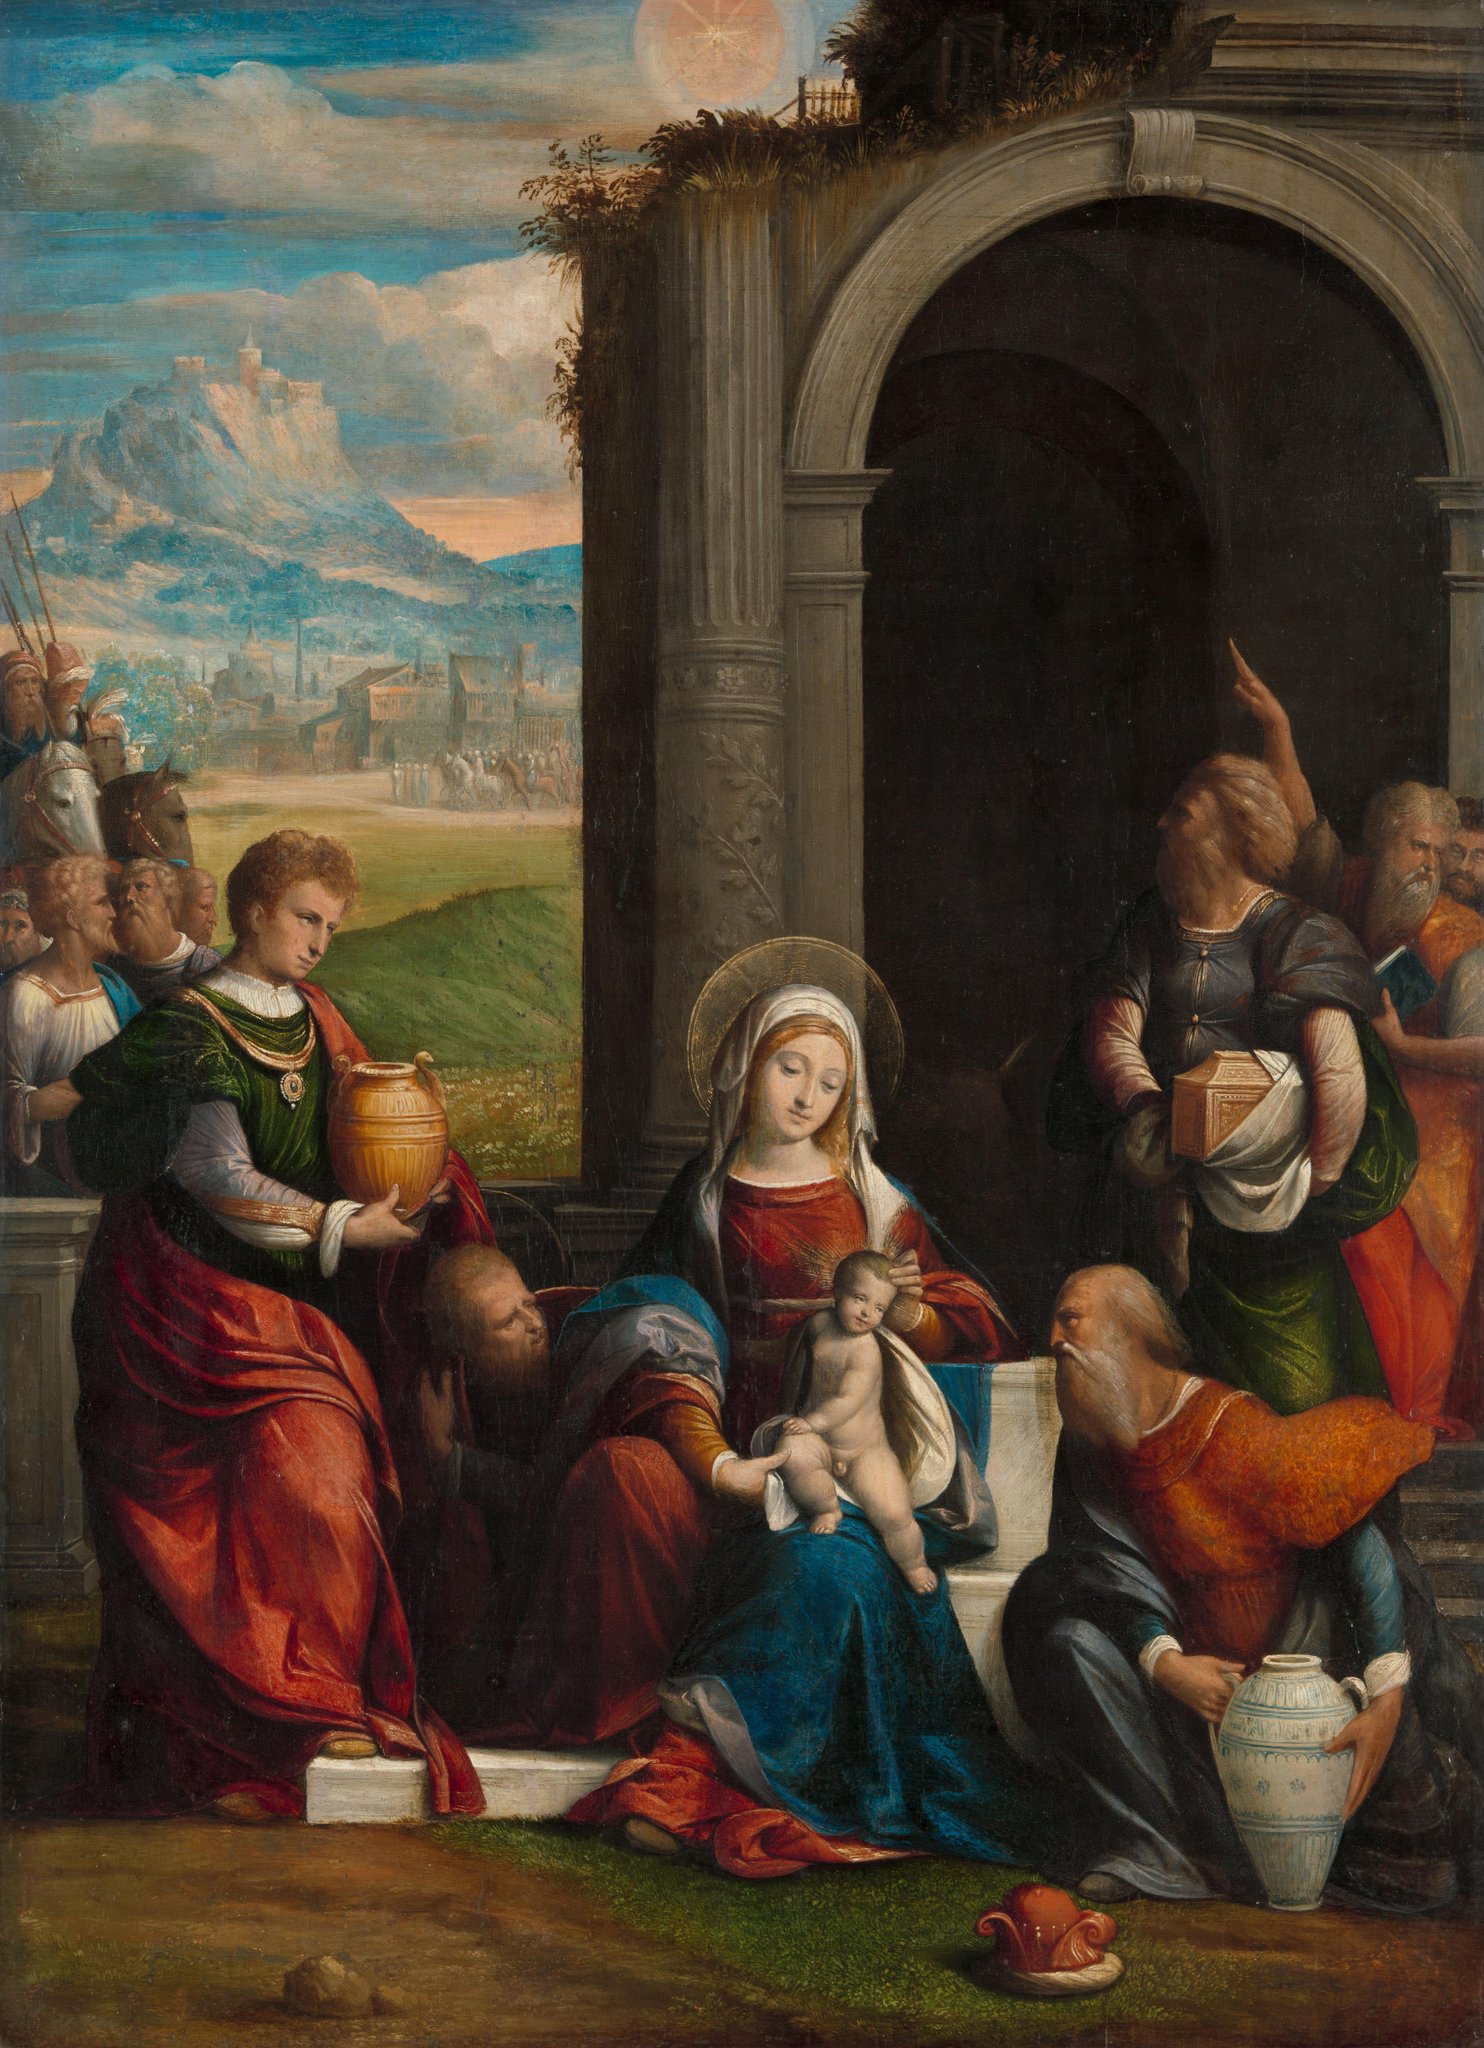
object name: painting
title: The Adoration of the Magi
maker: garofalo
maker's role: draughtsman, painter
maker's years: 1481-1559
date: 1530-1540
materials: oil, panel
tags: adoration of the kings: the wise men present their gifts to the christ-child (gold, frankincense and myrrh)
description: Benvenut Tisi, called il Garofalo (1481 - 1559). Adoration of the Magi, c. 1525. Purchased by King Willem I, 1823.